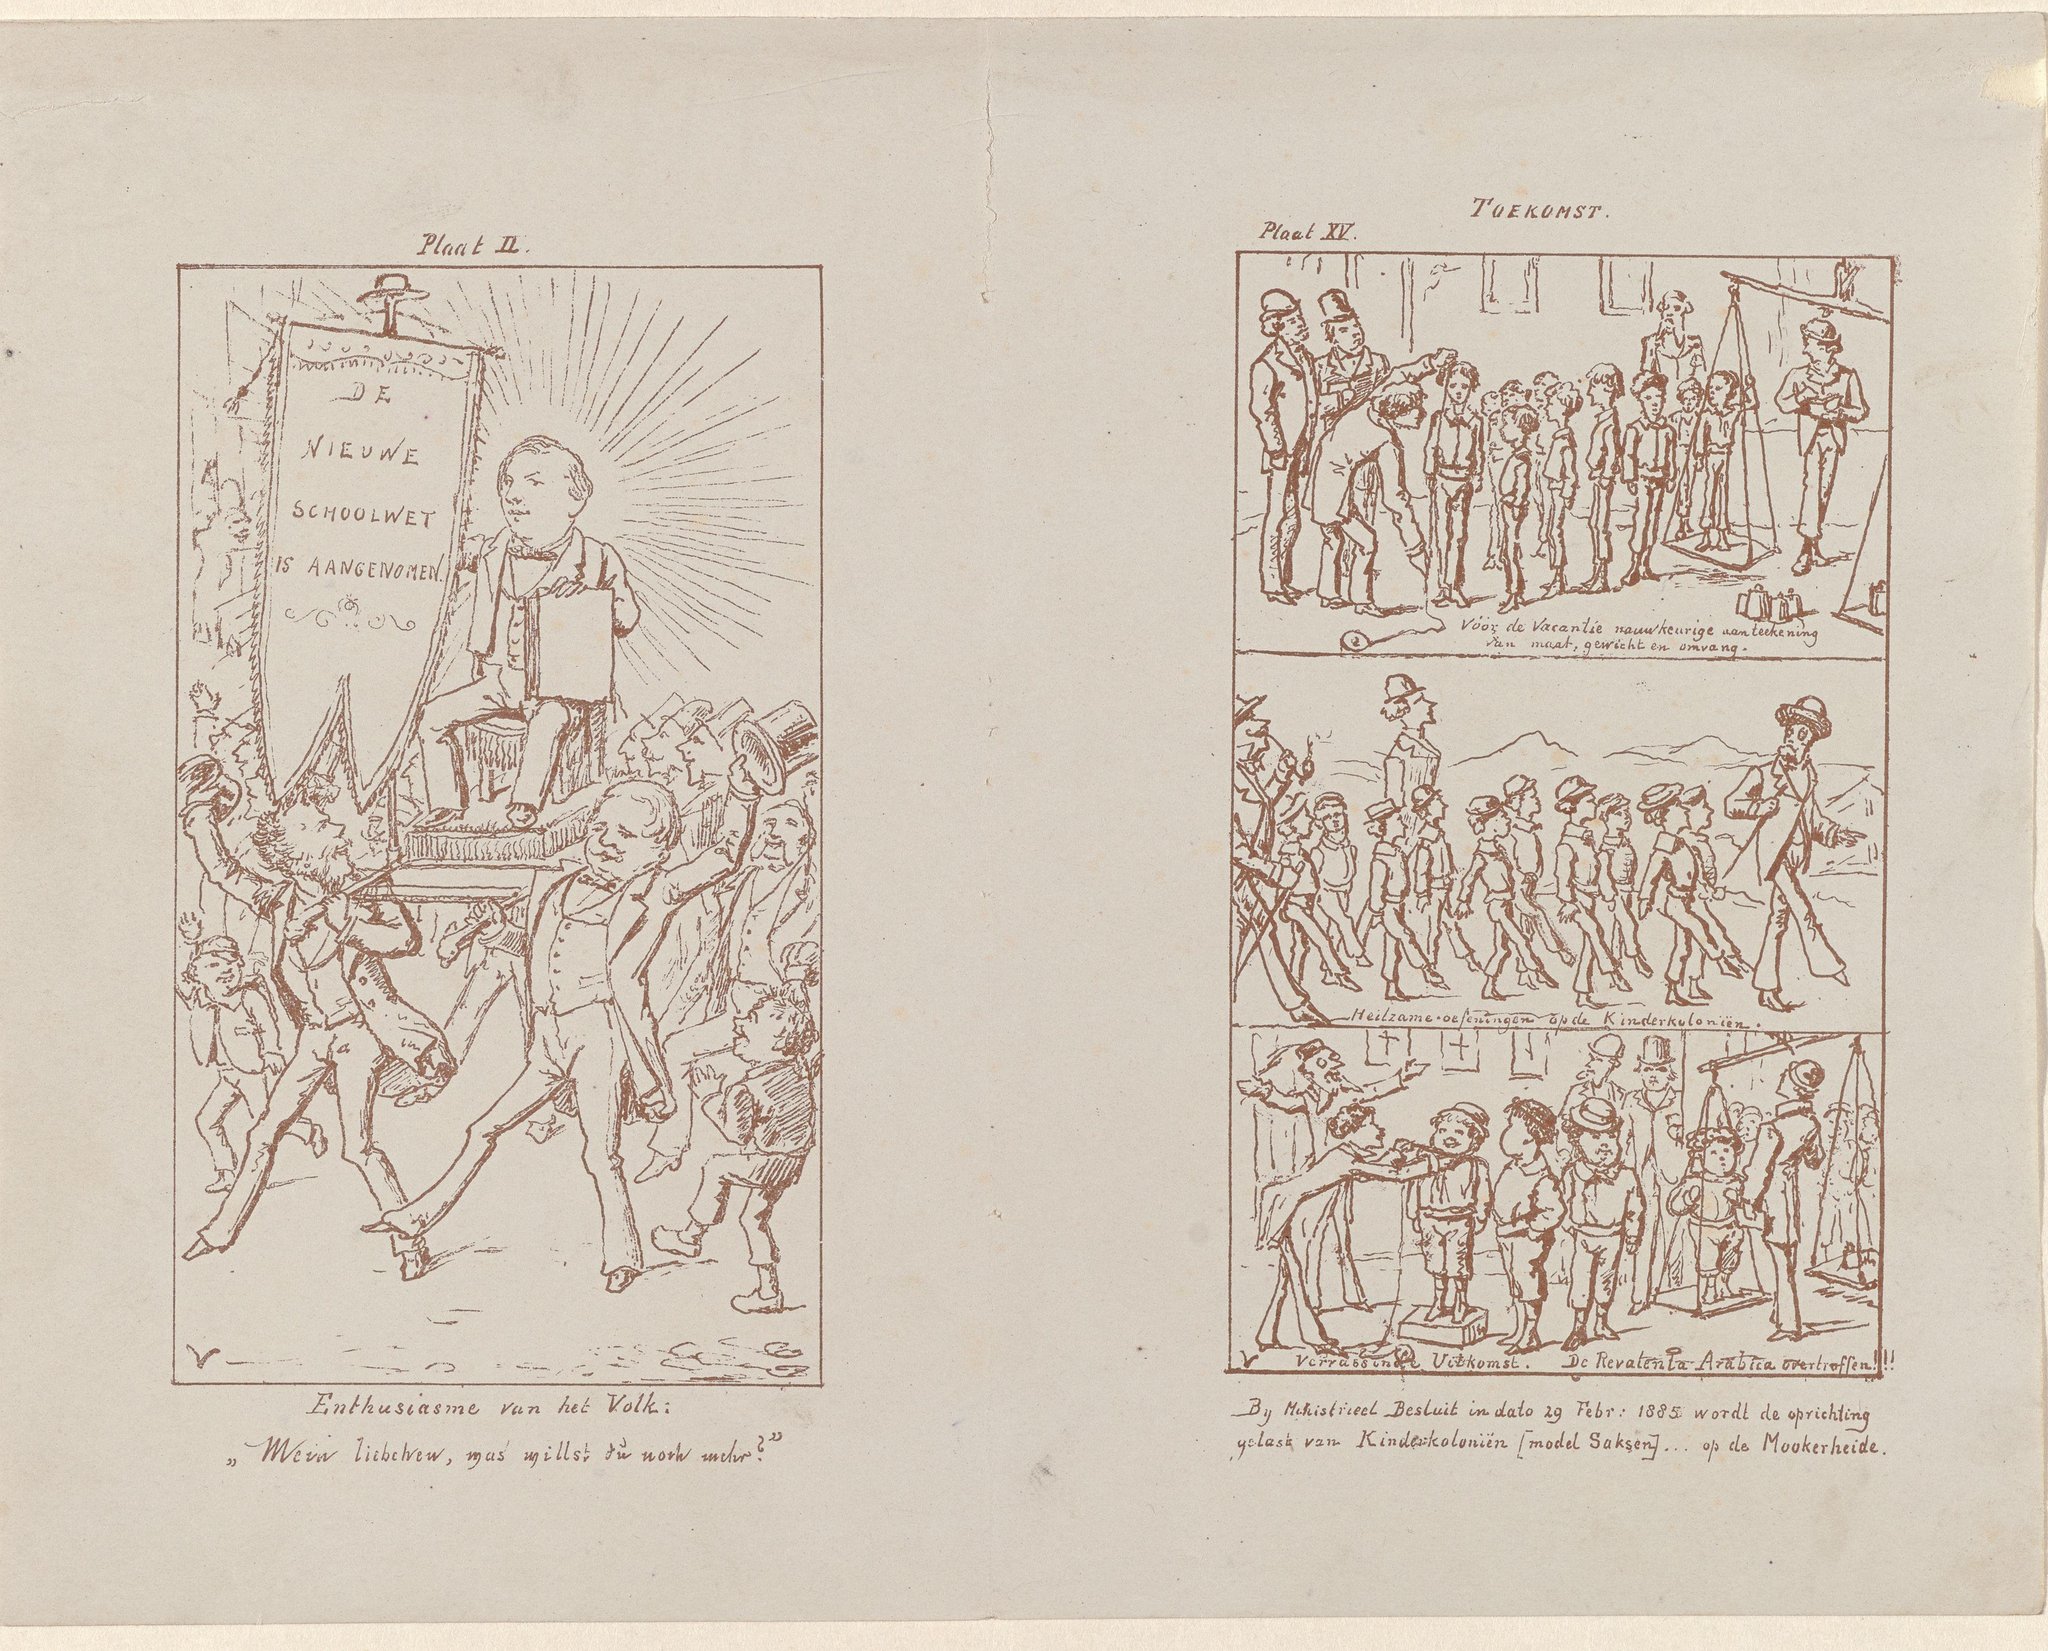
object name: print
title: Spotprenten uit het boekje Nieuwe Schoolwet en het Rapport der Commisssie, 1879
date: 1879-1880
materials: paper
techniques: lithograph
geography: rotterdam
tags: elementary school; class, form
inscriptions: collector's mark: Lugt 2228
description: Blad met de platen genummerd II en XV. Onderdeel van een serie van acht bladen, elk met twee spotprenten op de nieuwe wet op het Lager Onderwijs, genomen uit het boekje 'Nieuwe Schoolwet en het Rapport der Commisssie', door Veridicus, april 1879.